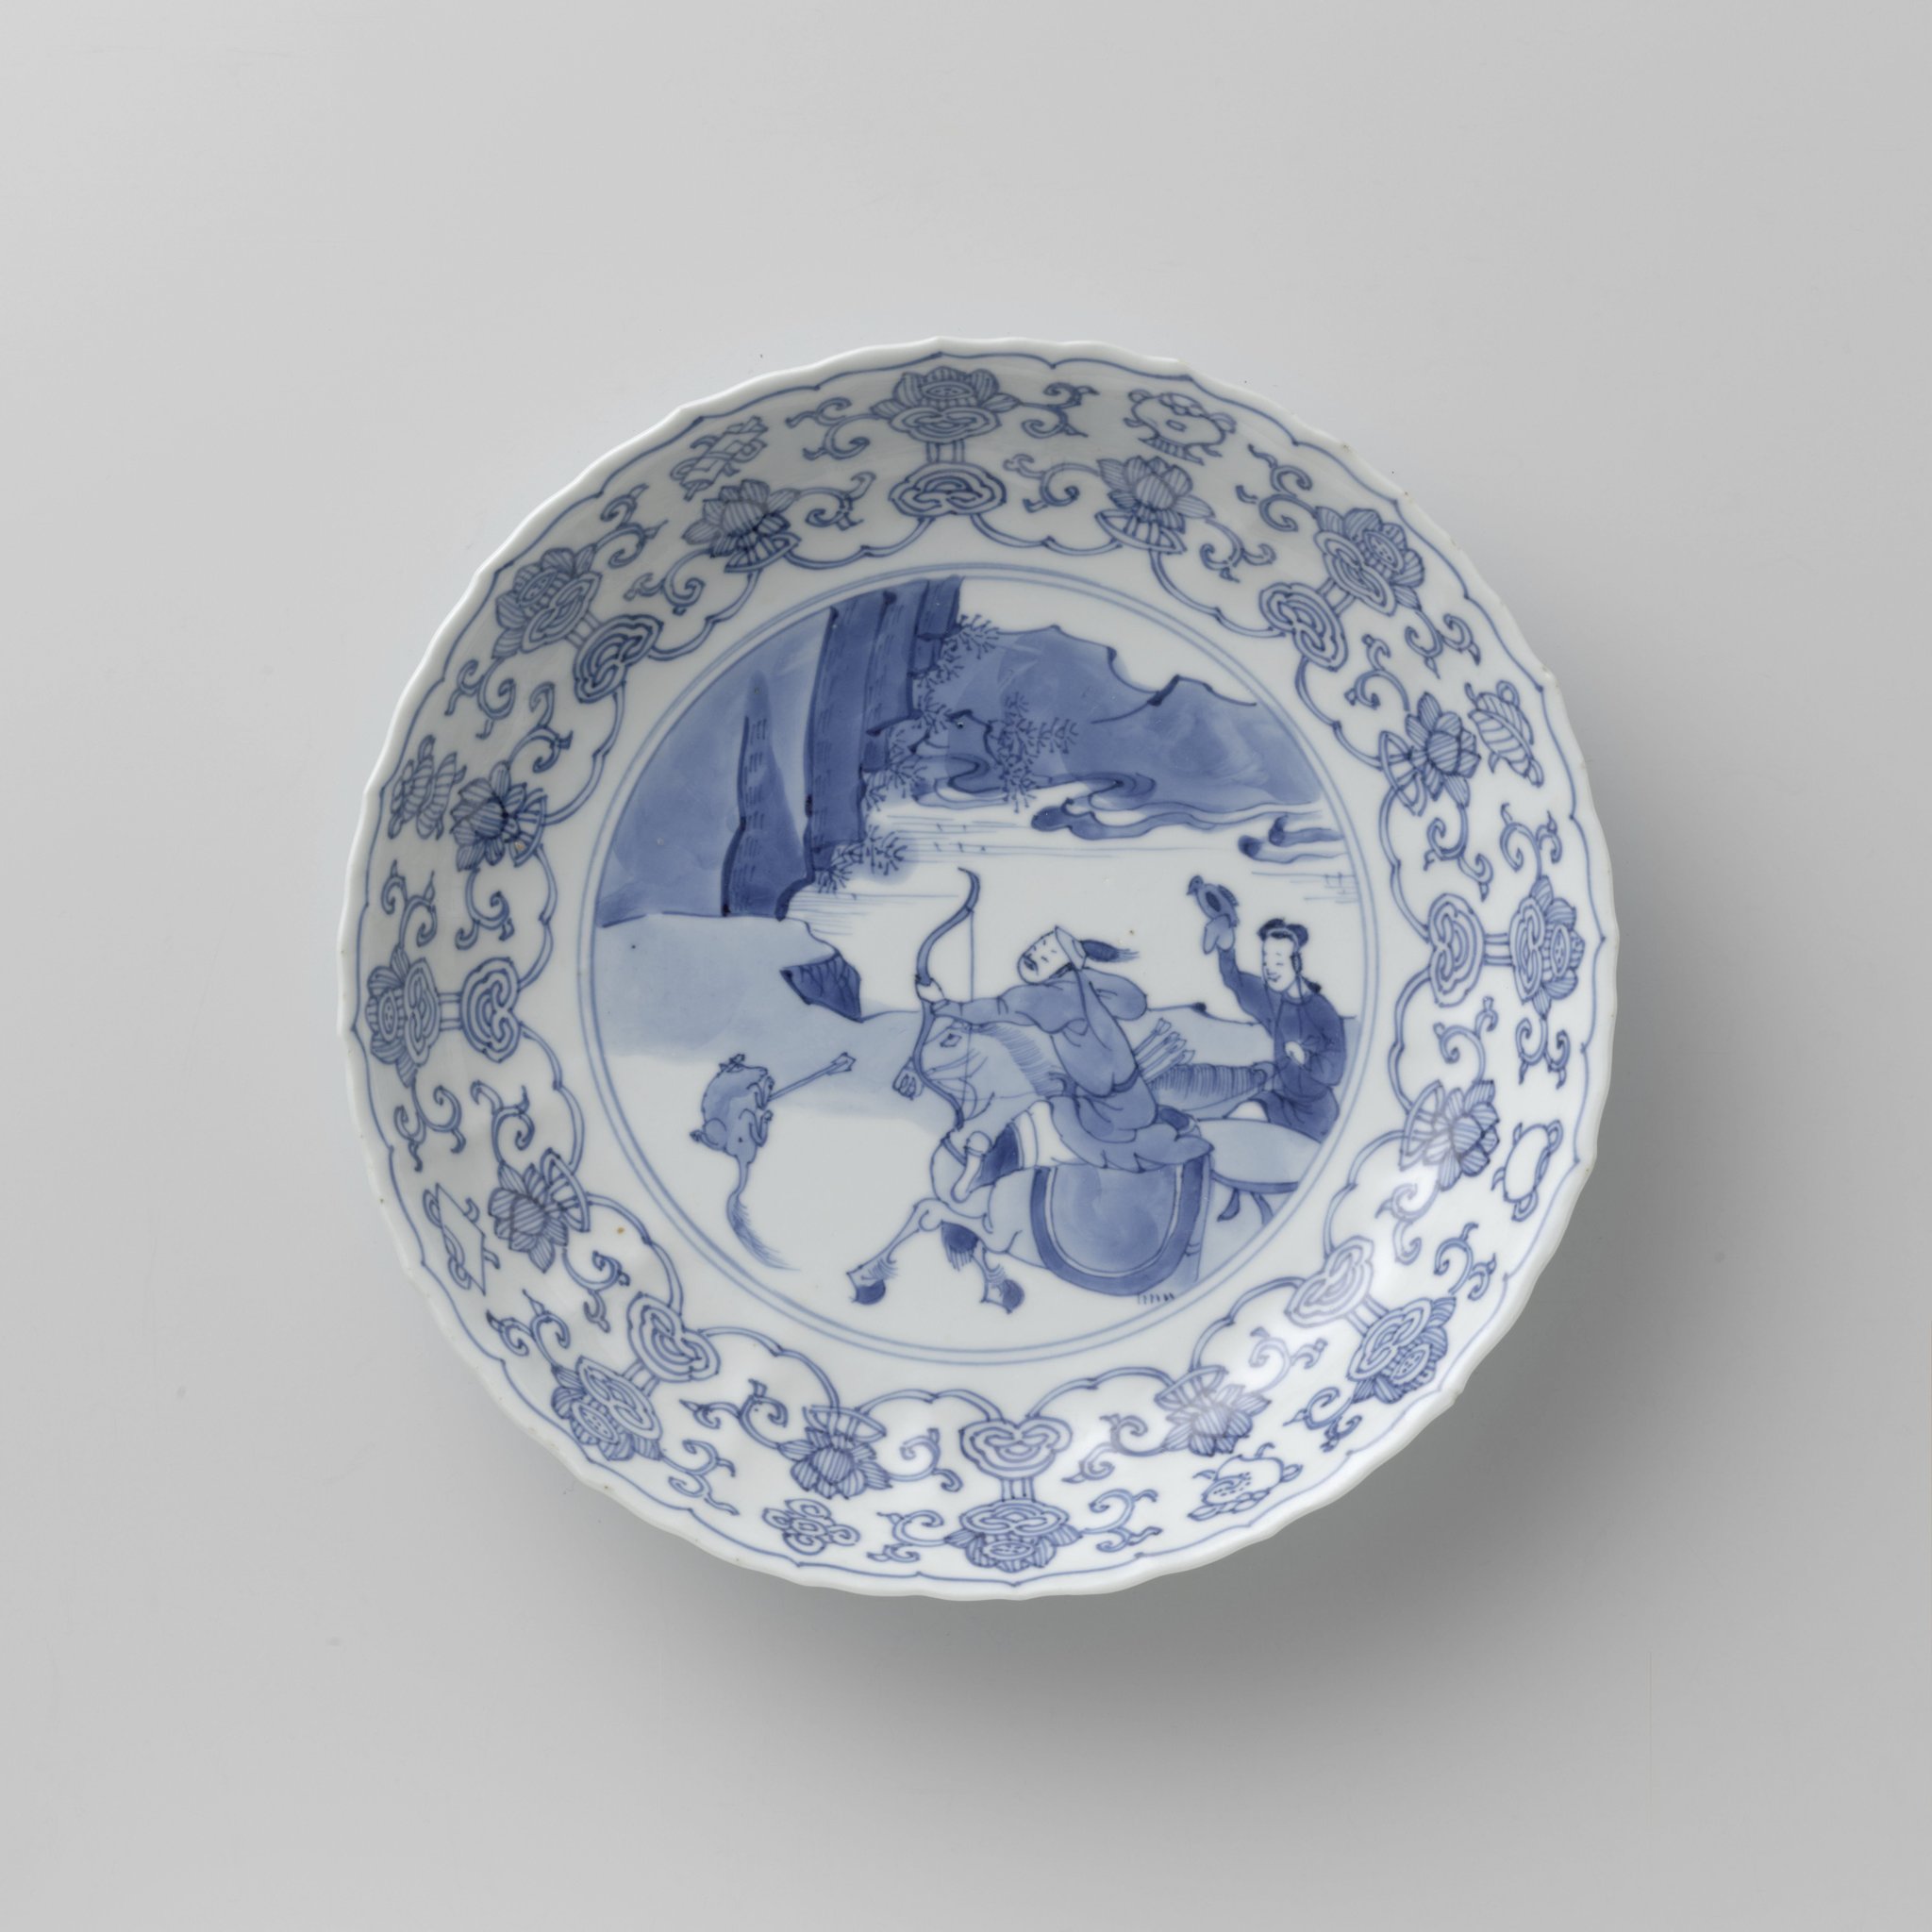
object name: dish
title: Saucer-dish with hunting scene, lotus scrolls and auspicious symbols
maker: Anonymous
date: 1700-1724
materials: cobalt, glaze, paint, porcelain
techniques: firing, forming, turning, vitrification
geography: china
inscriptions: mark: ‘大 明 成 化 年 製 dà míng Chéng huà nián zhì’